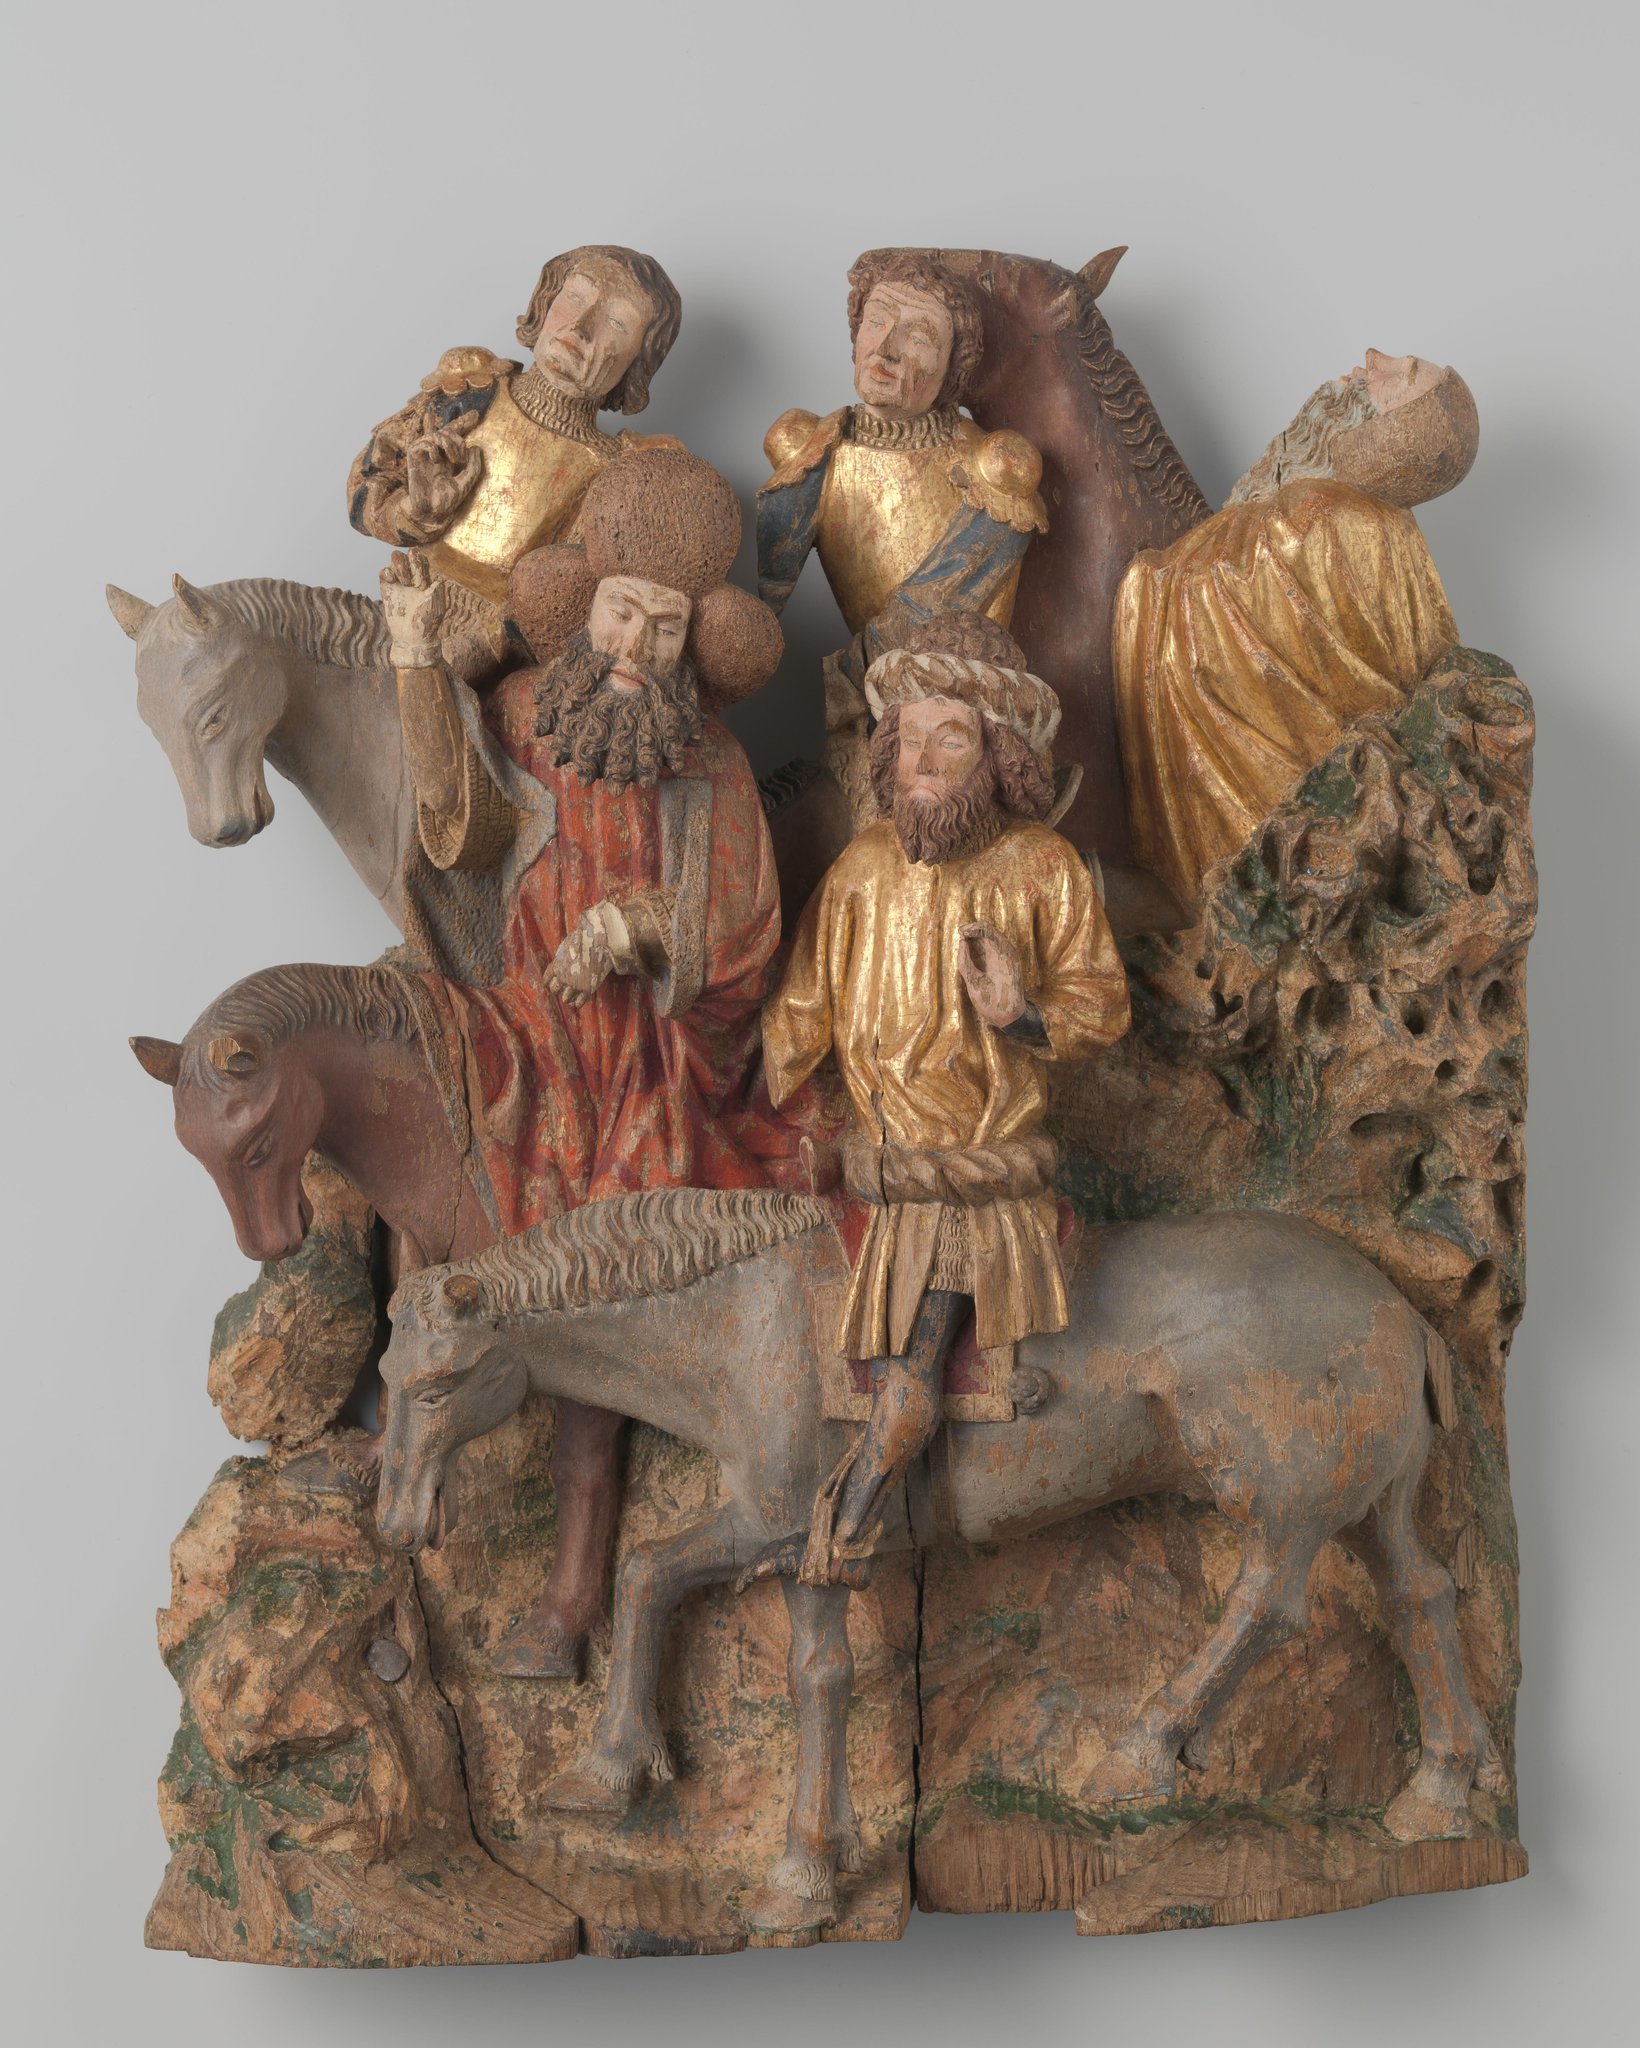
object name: sculpture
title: Two groups of horsemen from a Crucifixion scene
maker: Anonymous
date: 1440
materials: metal, wood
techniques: cutting, gilding, polychromy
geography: southern netherlands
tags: riding a horse, ass, or mule; rider, horseman, the crucifixion of christ: christ's death on the cross; golgotha (matthew 27:45-58; mark 15:33-45; luke 23:44-52; john 19:25-38), the centurion confessing his belief in christ; sometimes the soldiers do the same